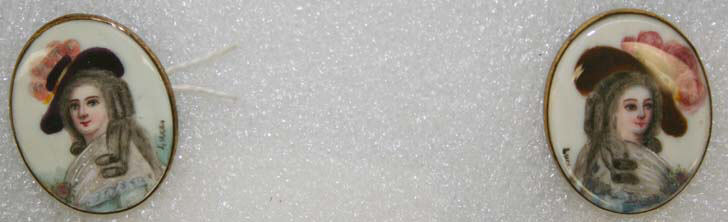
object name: button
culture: french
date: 1850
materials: ivory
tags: portraits,women